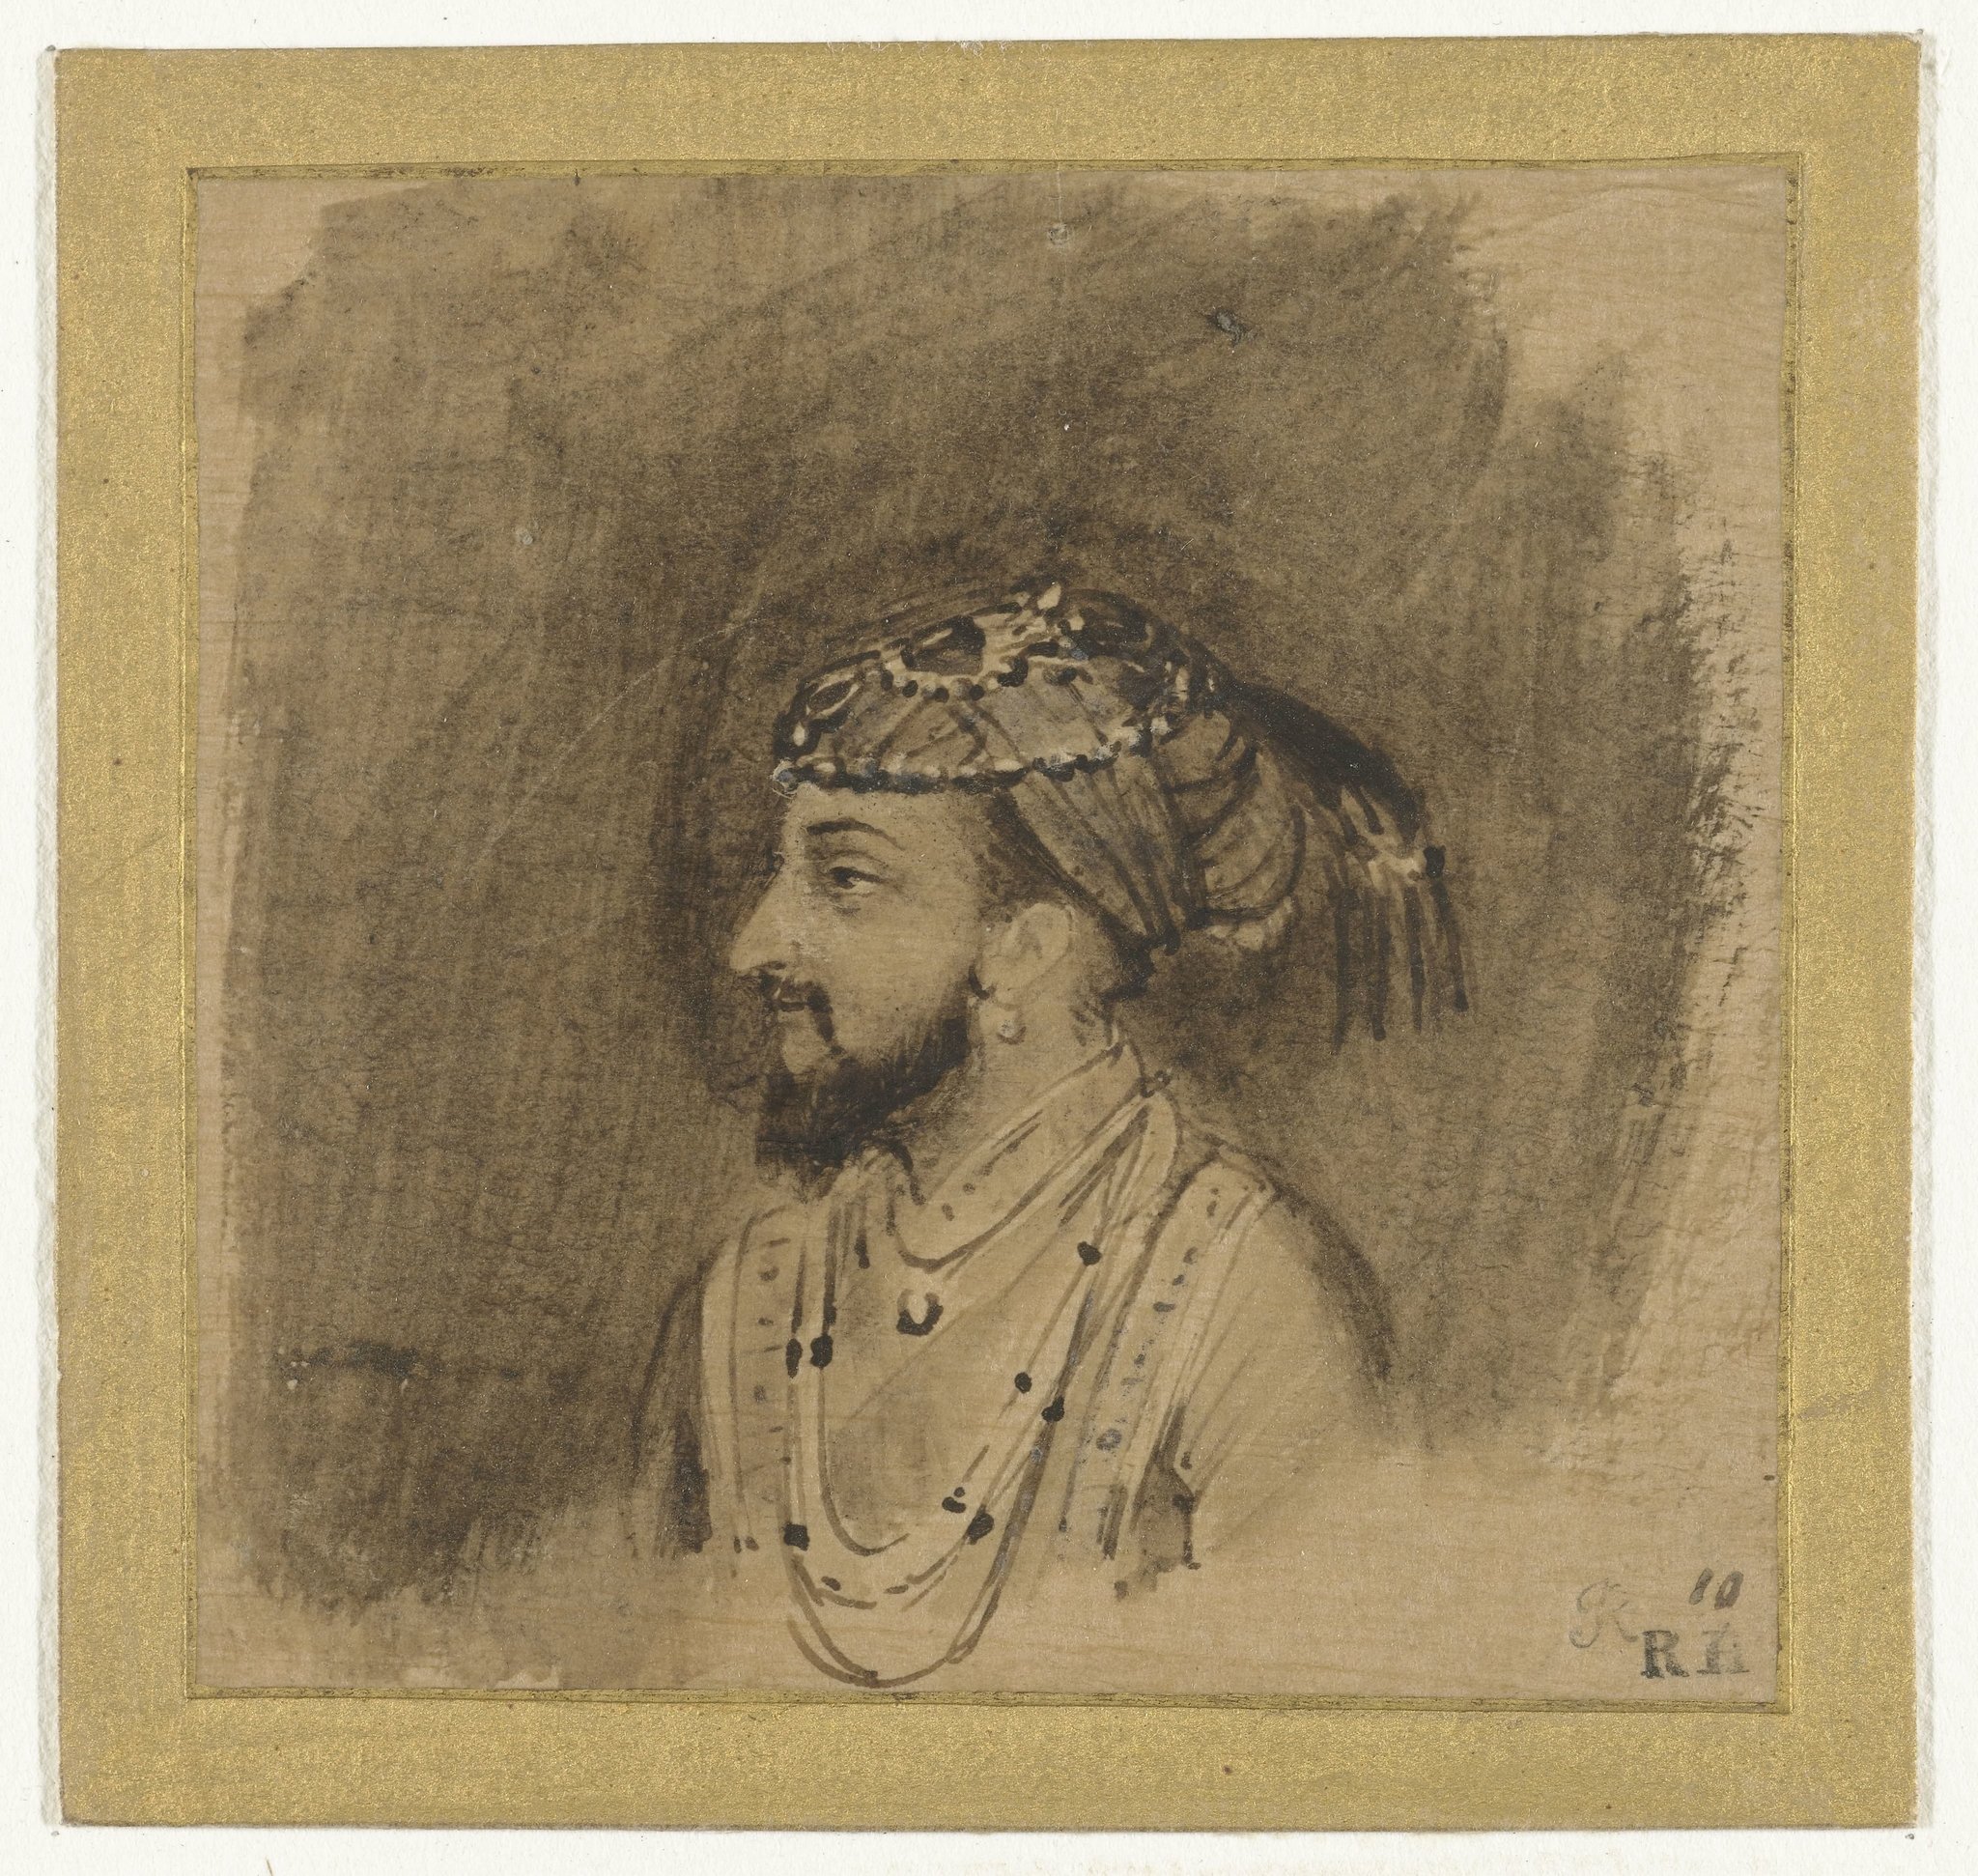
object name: drawing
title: Shah Jahan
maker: rembrandt van rijn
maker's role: draughtsman, painter, print maker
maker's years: 1606-1669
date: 1656-1658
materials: paint, ink, paper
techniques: brush, pen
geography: amsterdam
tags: historical persons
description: Kopie naar miniatuur. Marijn Schapelhouman, Rembrandt en de kunst van het tekenen, Zwolle/Amsterdam 2006, p. 21, kleurafb. 15